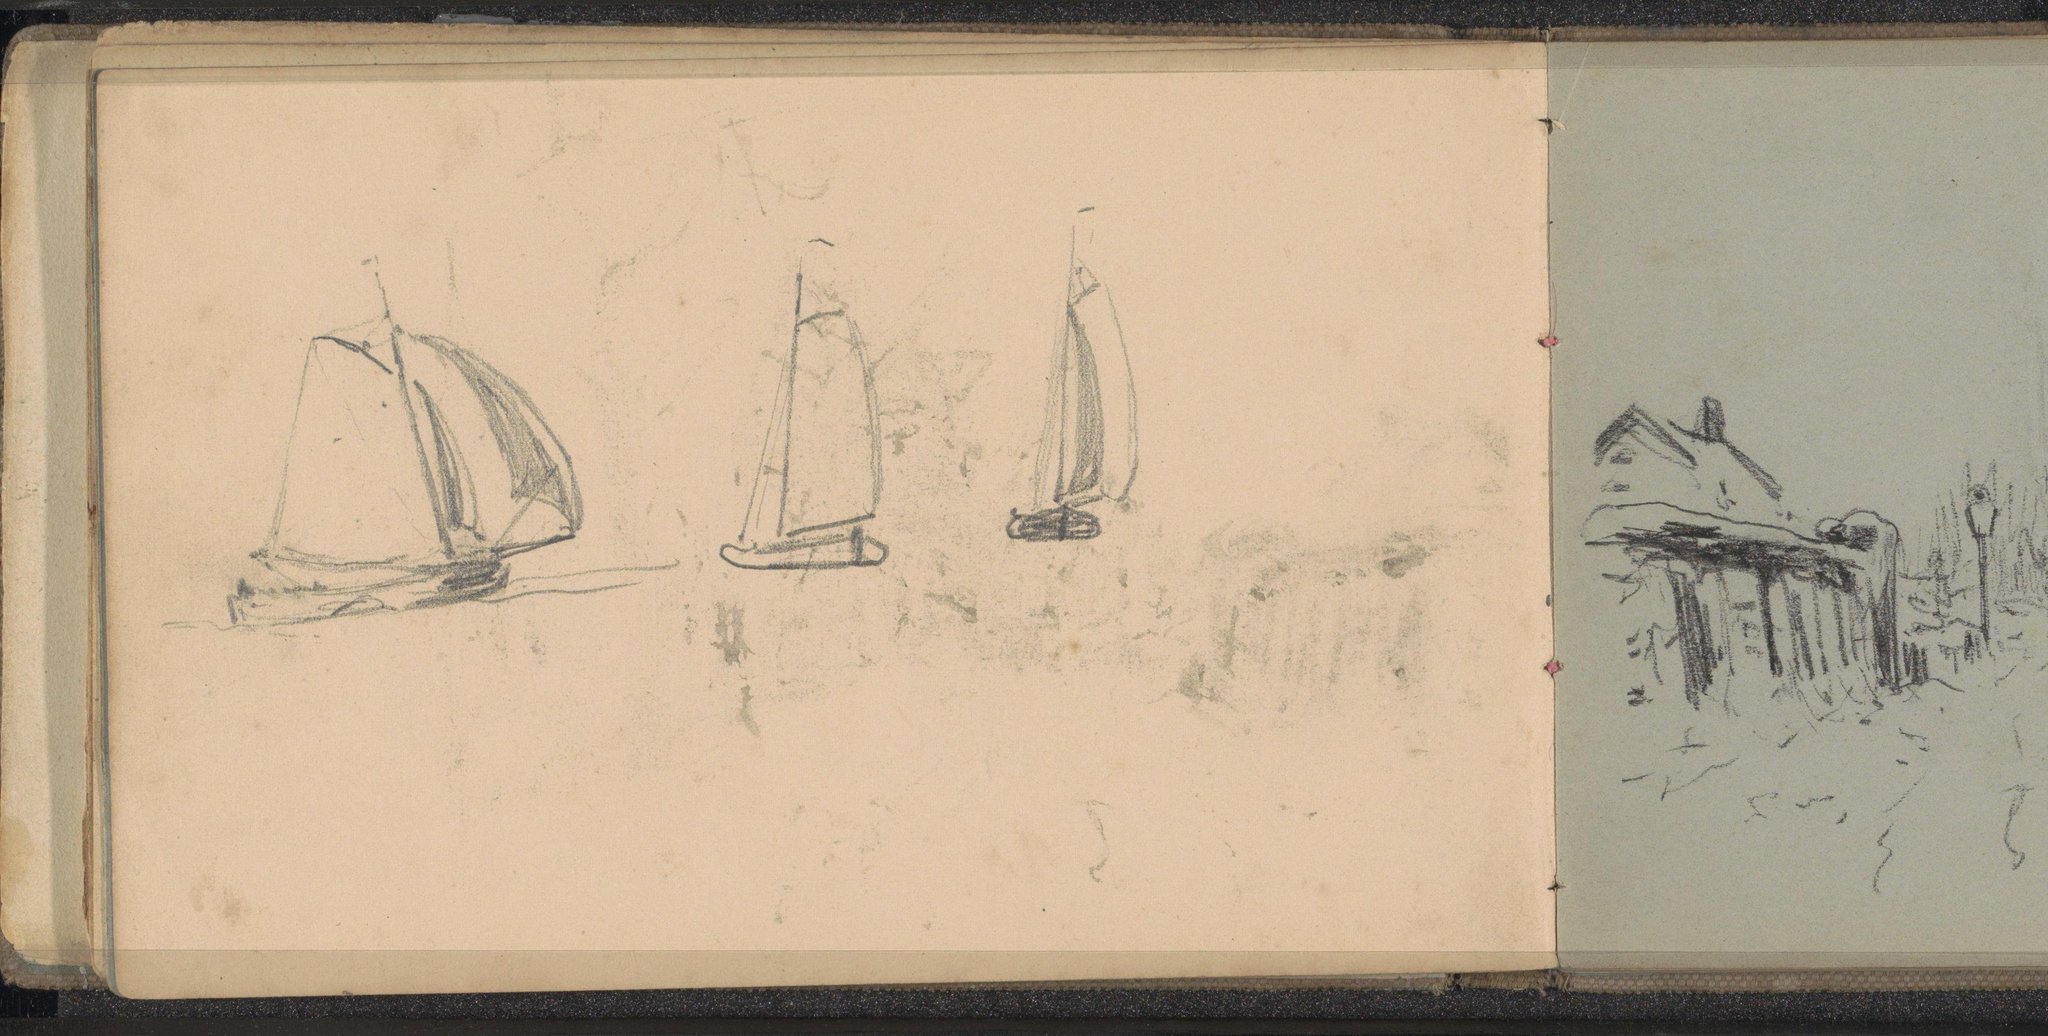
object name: sketchbook leaf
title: Studieblad met schepen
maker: louis apol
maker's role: draughtsman, painter, print maker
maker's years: 1850-1936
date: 1809-1880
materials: paper, pencil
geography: norway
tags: ships (in general)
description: Blad 21 verso uit een schetsboek met 38 bladen betekend tijdens de expeditie naar Nova Zembla in 1880.